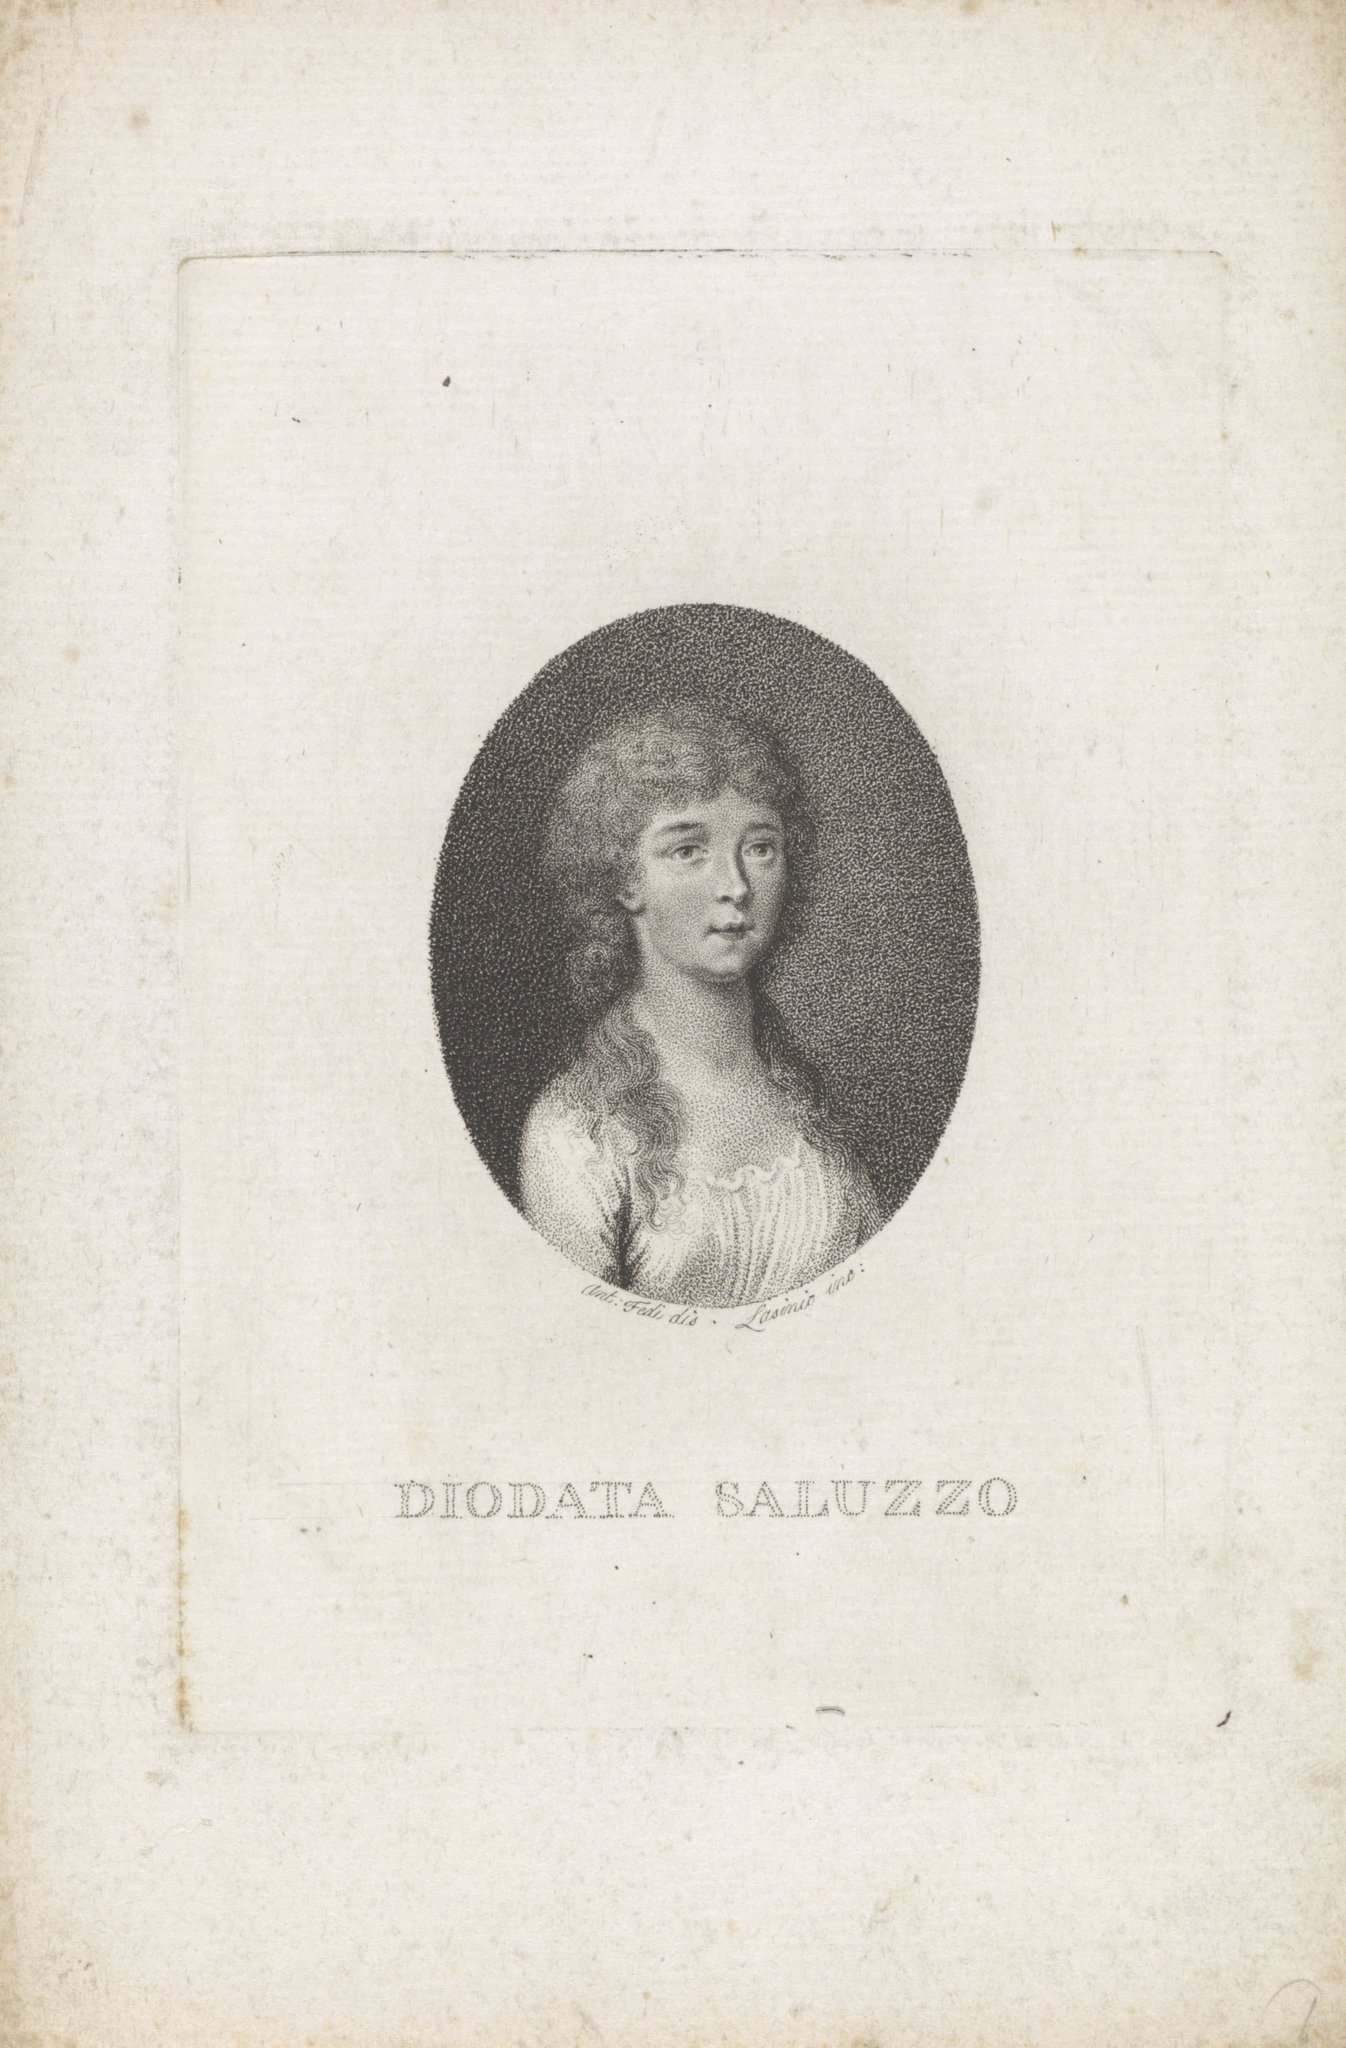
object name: print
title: Portret van dichteres en schrijfster Diodata Saluzzo Roero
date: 1769-1838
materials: paper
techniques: stippling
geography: italy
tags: historical persons, portrait of a writer, writer, poet, author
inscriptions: collector's mark: Lugt 2228